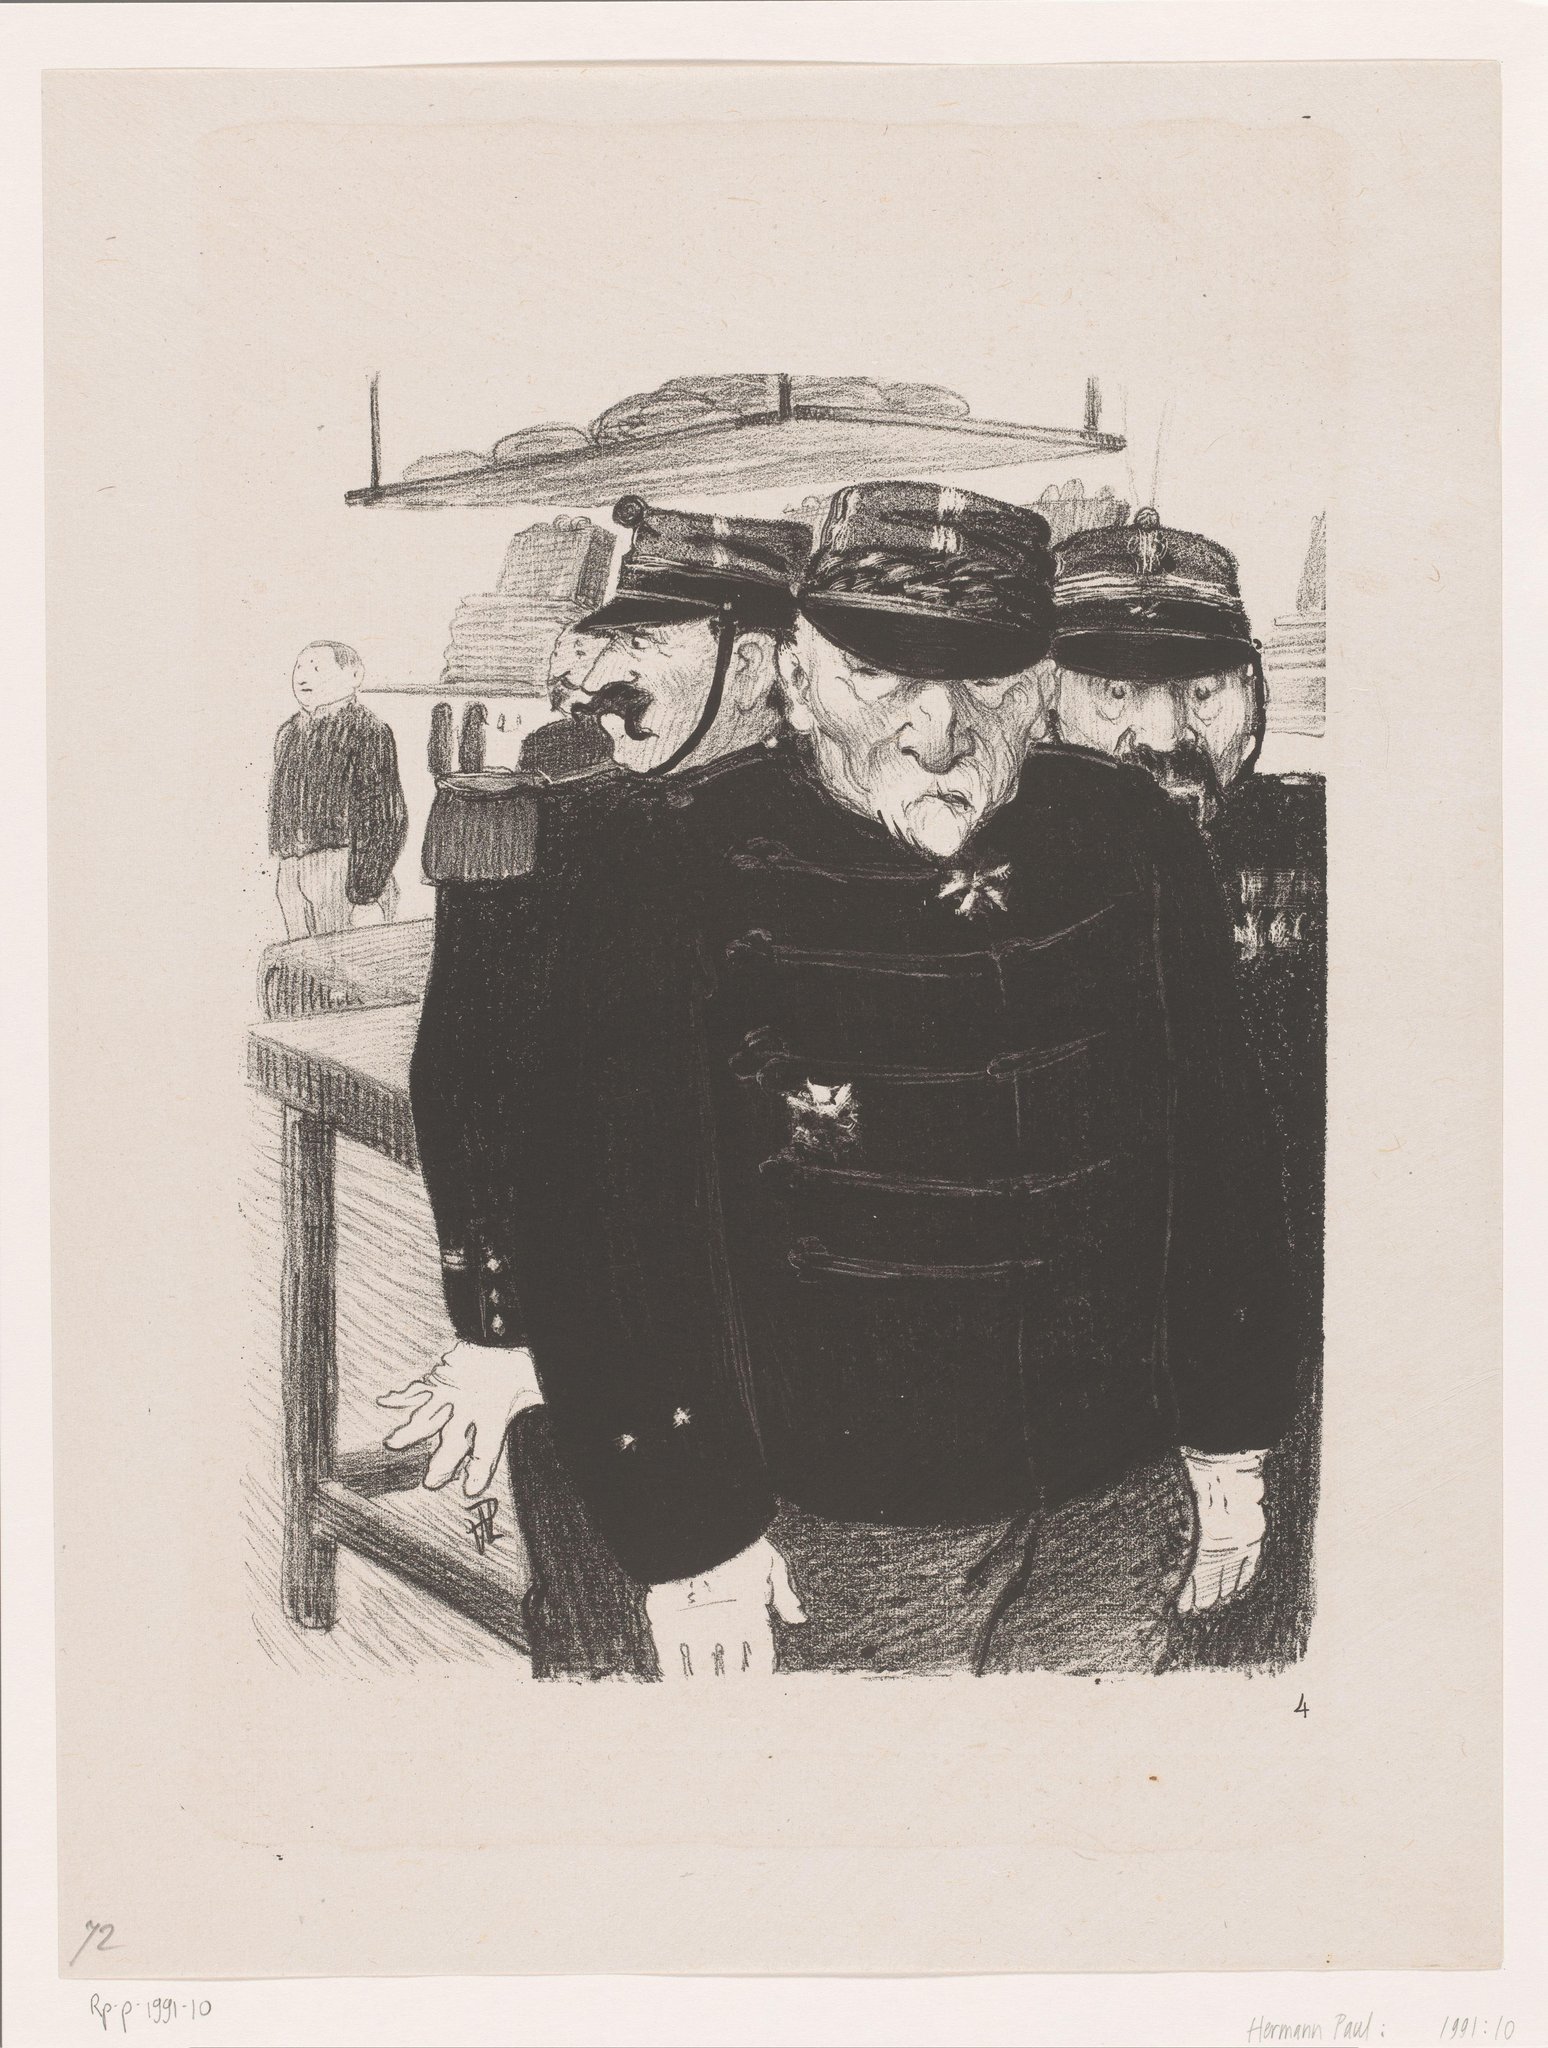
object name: print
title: Le grands spectacles de la nature; la vie de monsieur Quelconque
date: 1895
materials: paper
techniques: lithograph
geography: paris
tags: the soldier; the soldier's life, (military) uniforms